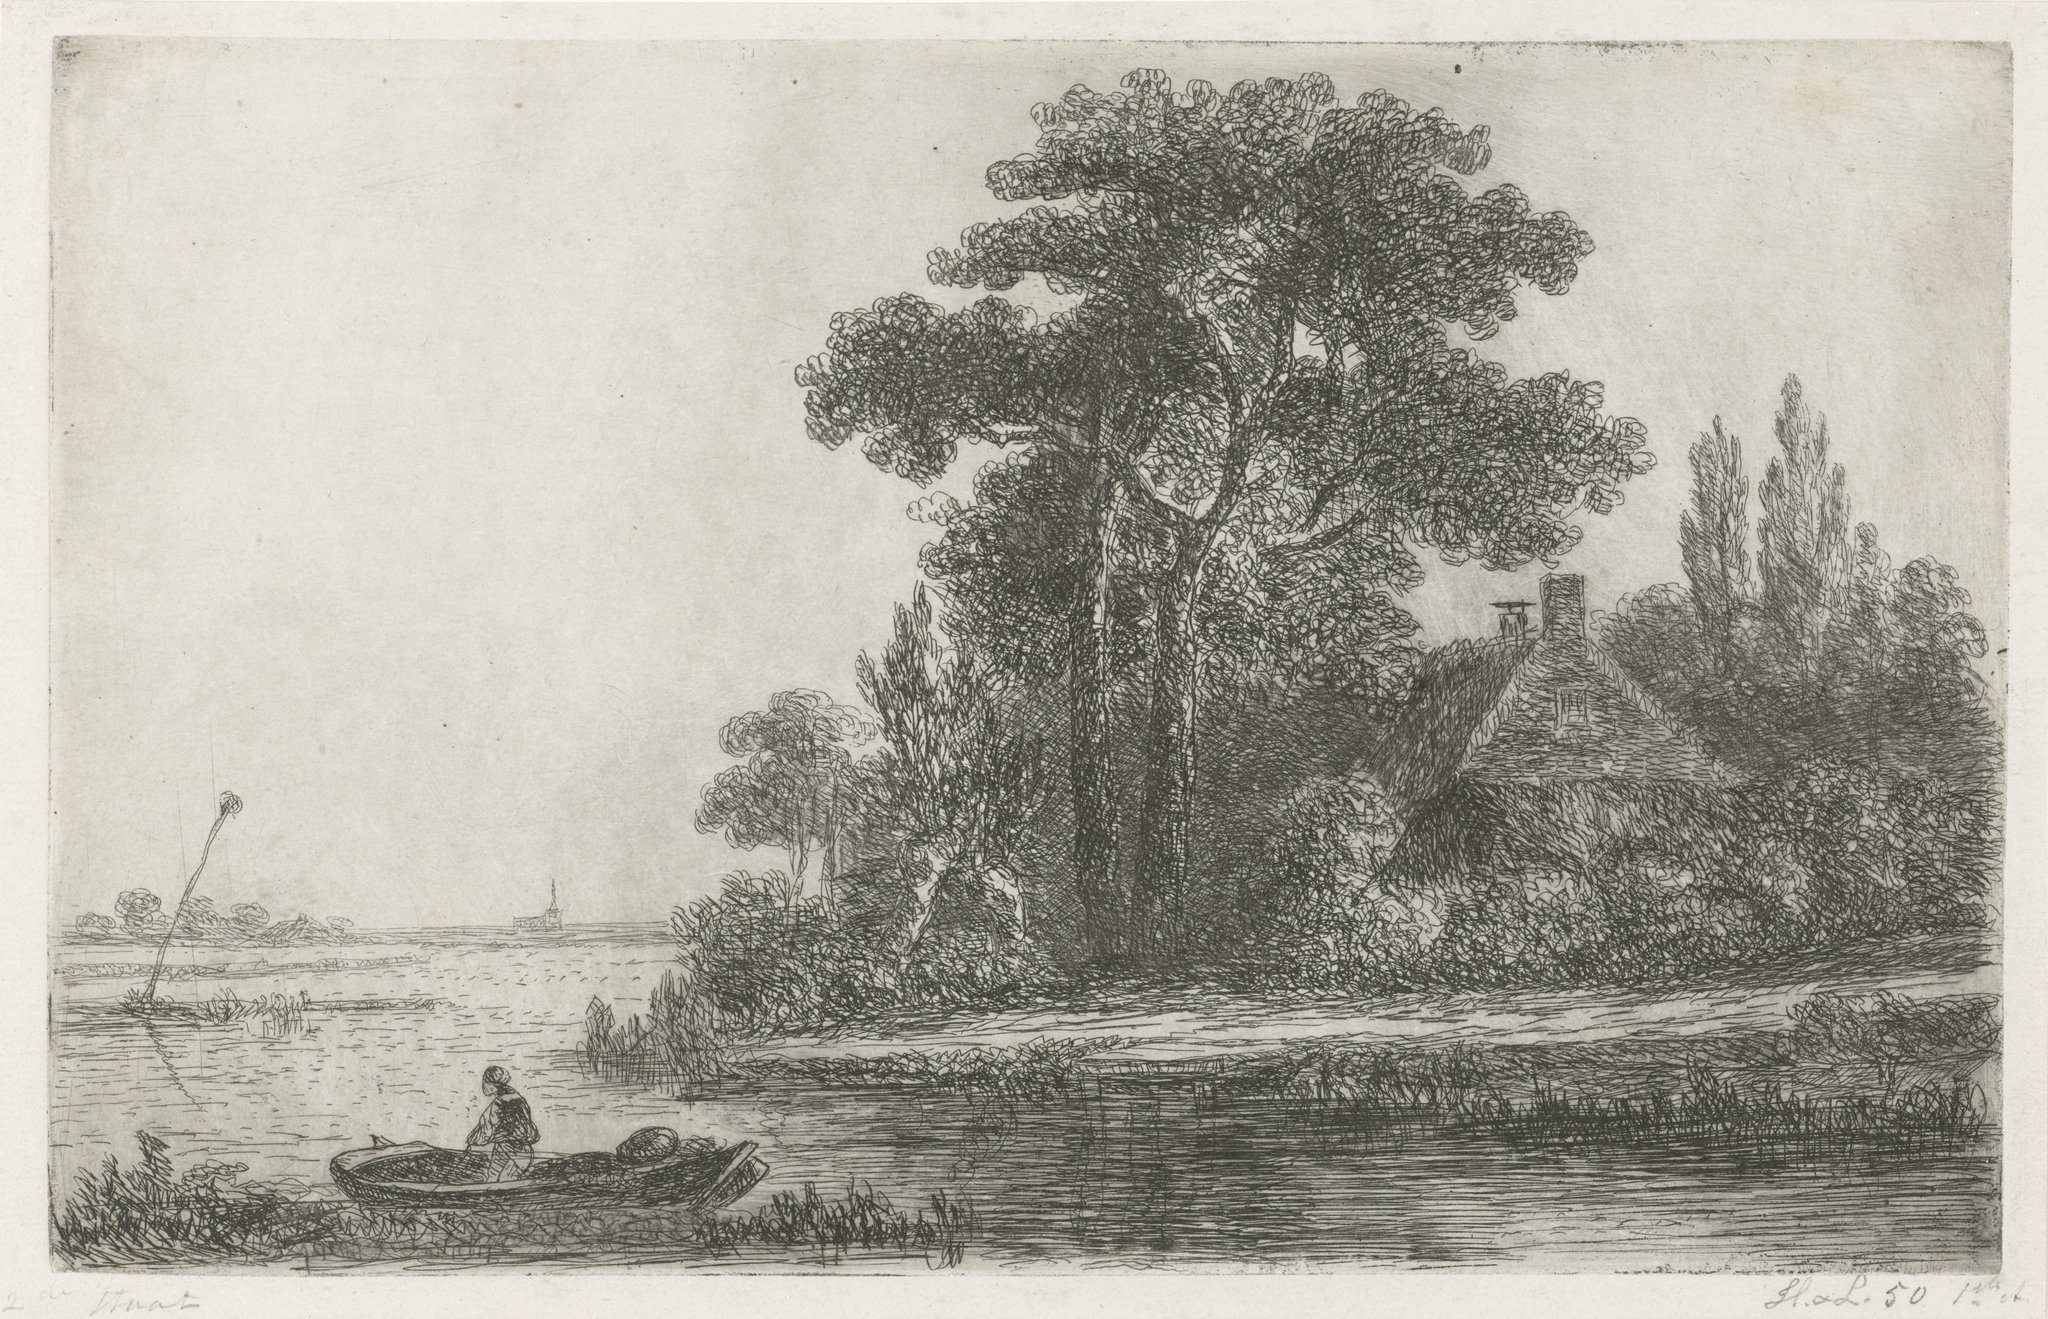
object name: print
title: Rivierlandschap met baken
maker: hermanus jan hendrik van rijkelijkhuysen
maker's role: painter, print maker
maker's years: 1813-1883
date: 1857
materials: paper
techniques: drypoint, etching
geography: utrecht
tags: river, church (exterior), rowing-boat, canoe, etc., beacon, farm or solitary house in landscape, fisherman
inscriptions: collector's mark: Lugt 2228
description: Een rivierlandschap met links een baken en op de voorgrond een visser in een boot. Rechts een boerenhoeve en op de achtergrond de contouren van een kerk.